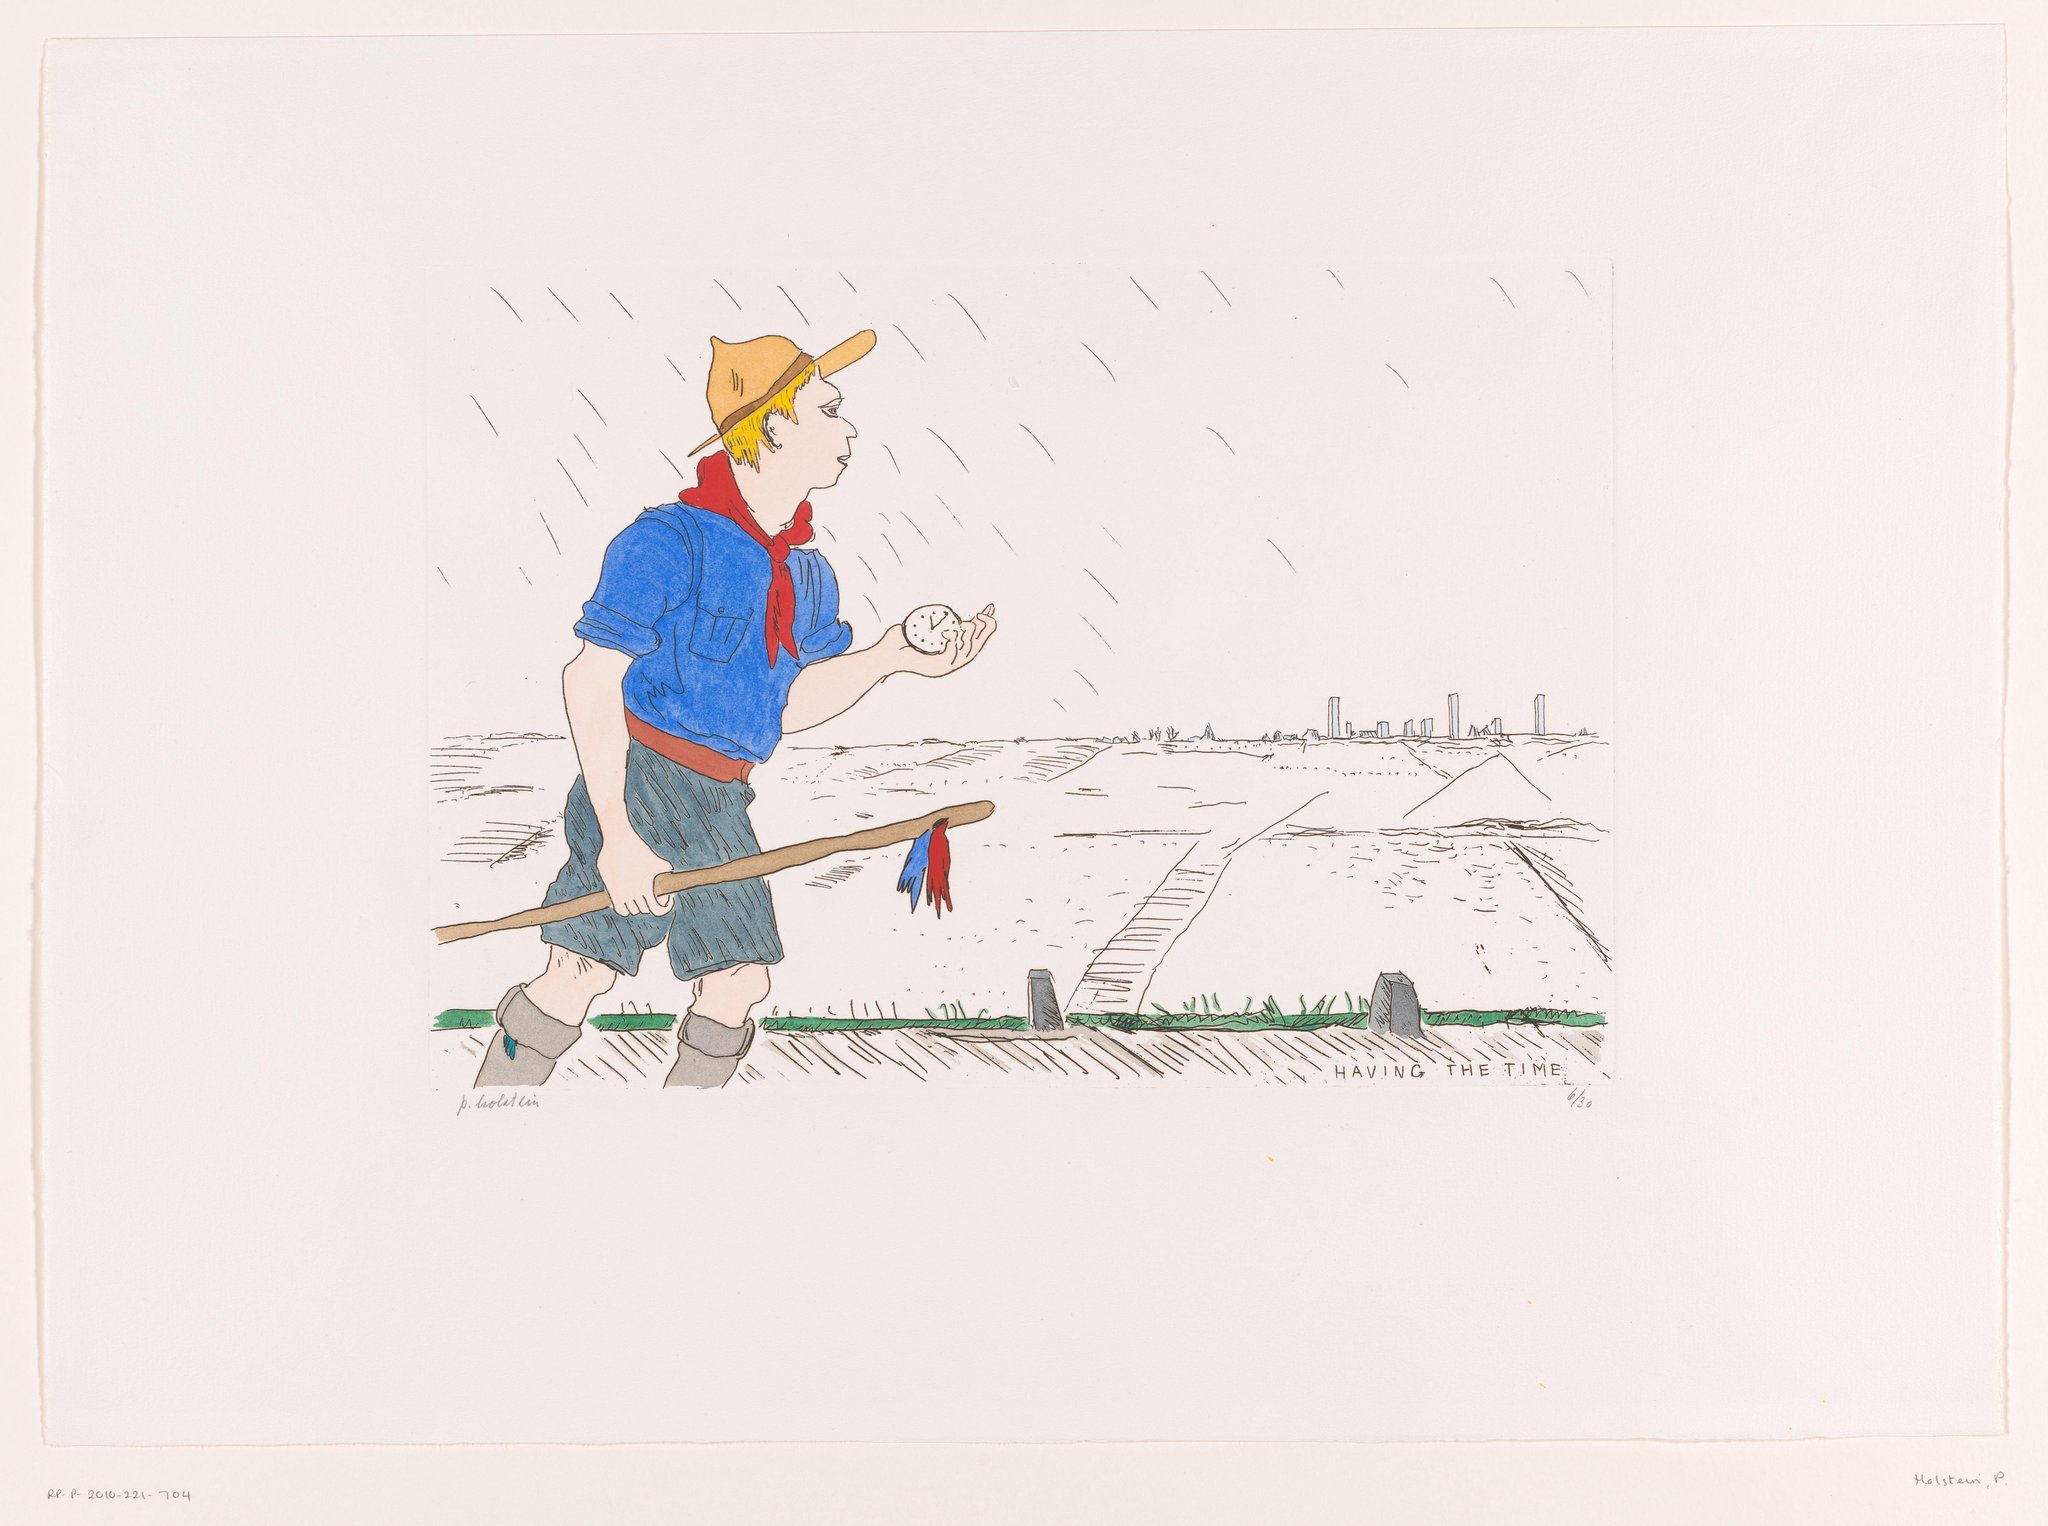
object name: print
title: Having the Time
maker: pieter holstein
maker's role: draughtsman, painter, print maker, sculptor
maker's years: 1934-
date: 1975-1977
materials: paper, watercolor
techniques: brush, etching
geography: amsterdam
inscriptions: title: ‘HAVING THE TIME’, edition: ‘6/30’, signature: ‘p. holstein’